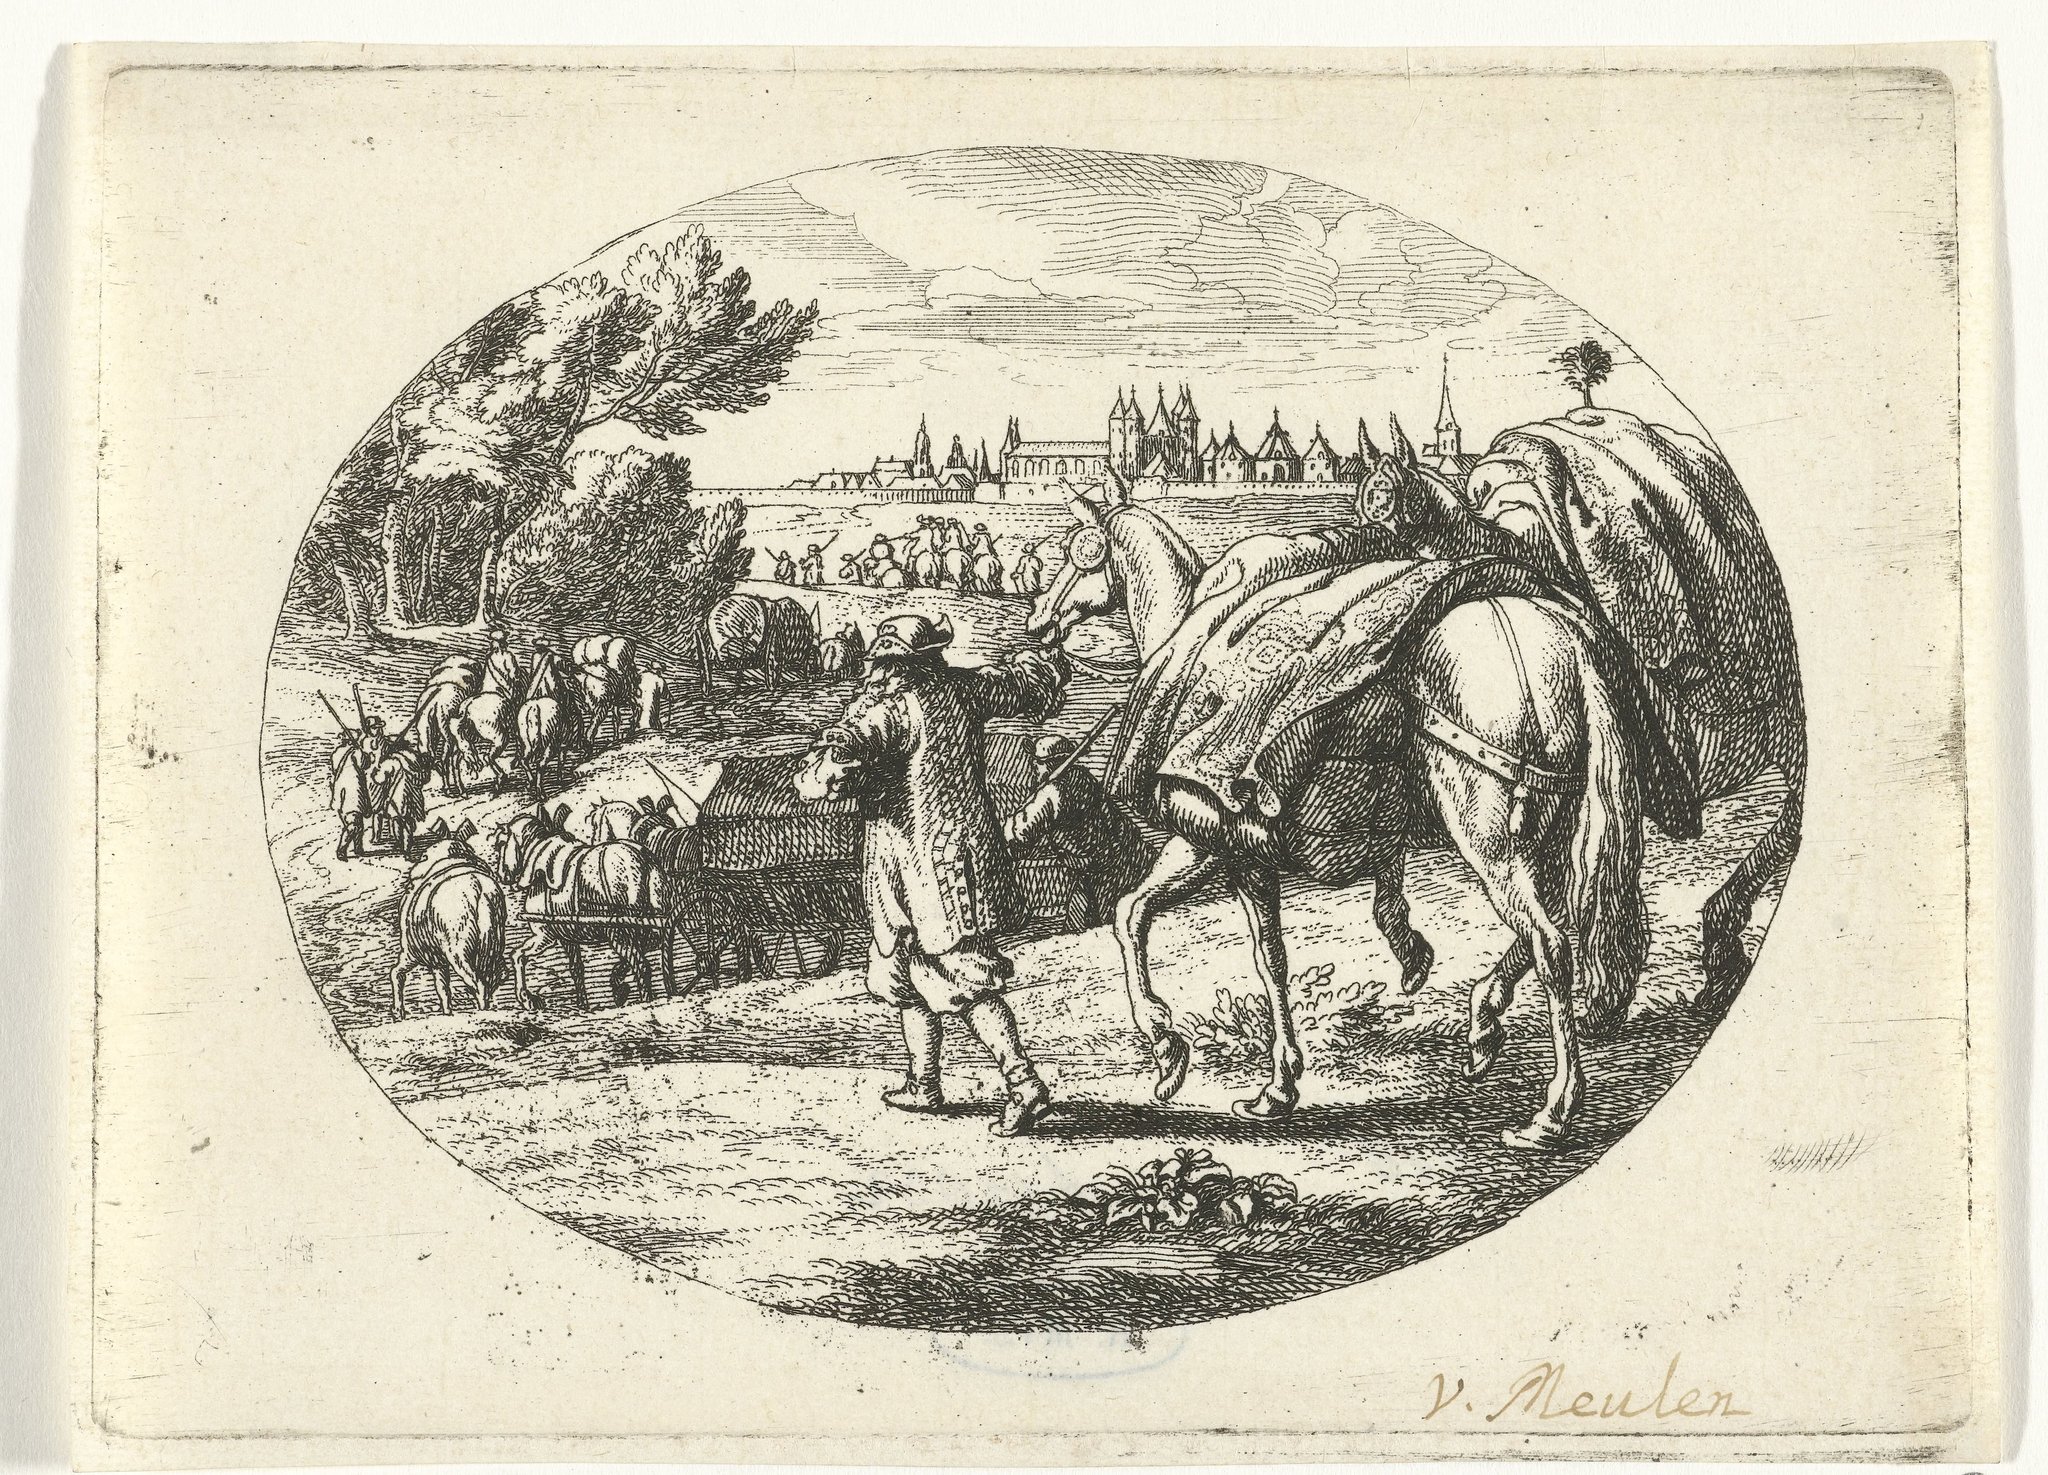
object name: print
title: Optrekkend leger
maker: jan van huchtenburg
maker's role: draughtsman, painter, print maker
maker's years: 1647-1733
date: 1674-1733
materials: paper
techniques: etching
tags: lodewijk xiv (koning van frankrijk), historical persons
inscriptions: inscription: ‘V. Meulen’, collector's mark: Lugt 2228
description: Een stoet van ruiters, paarden en wagens trekt naar een stad aan de horizon.